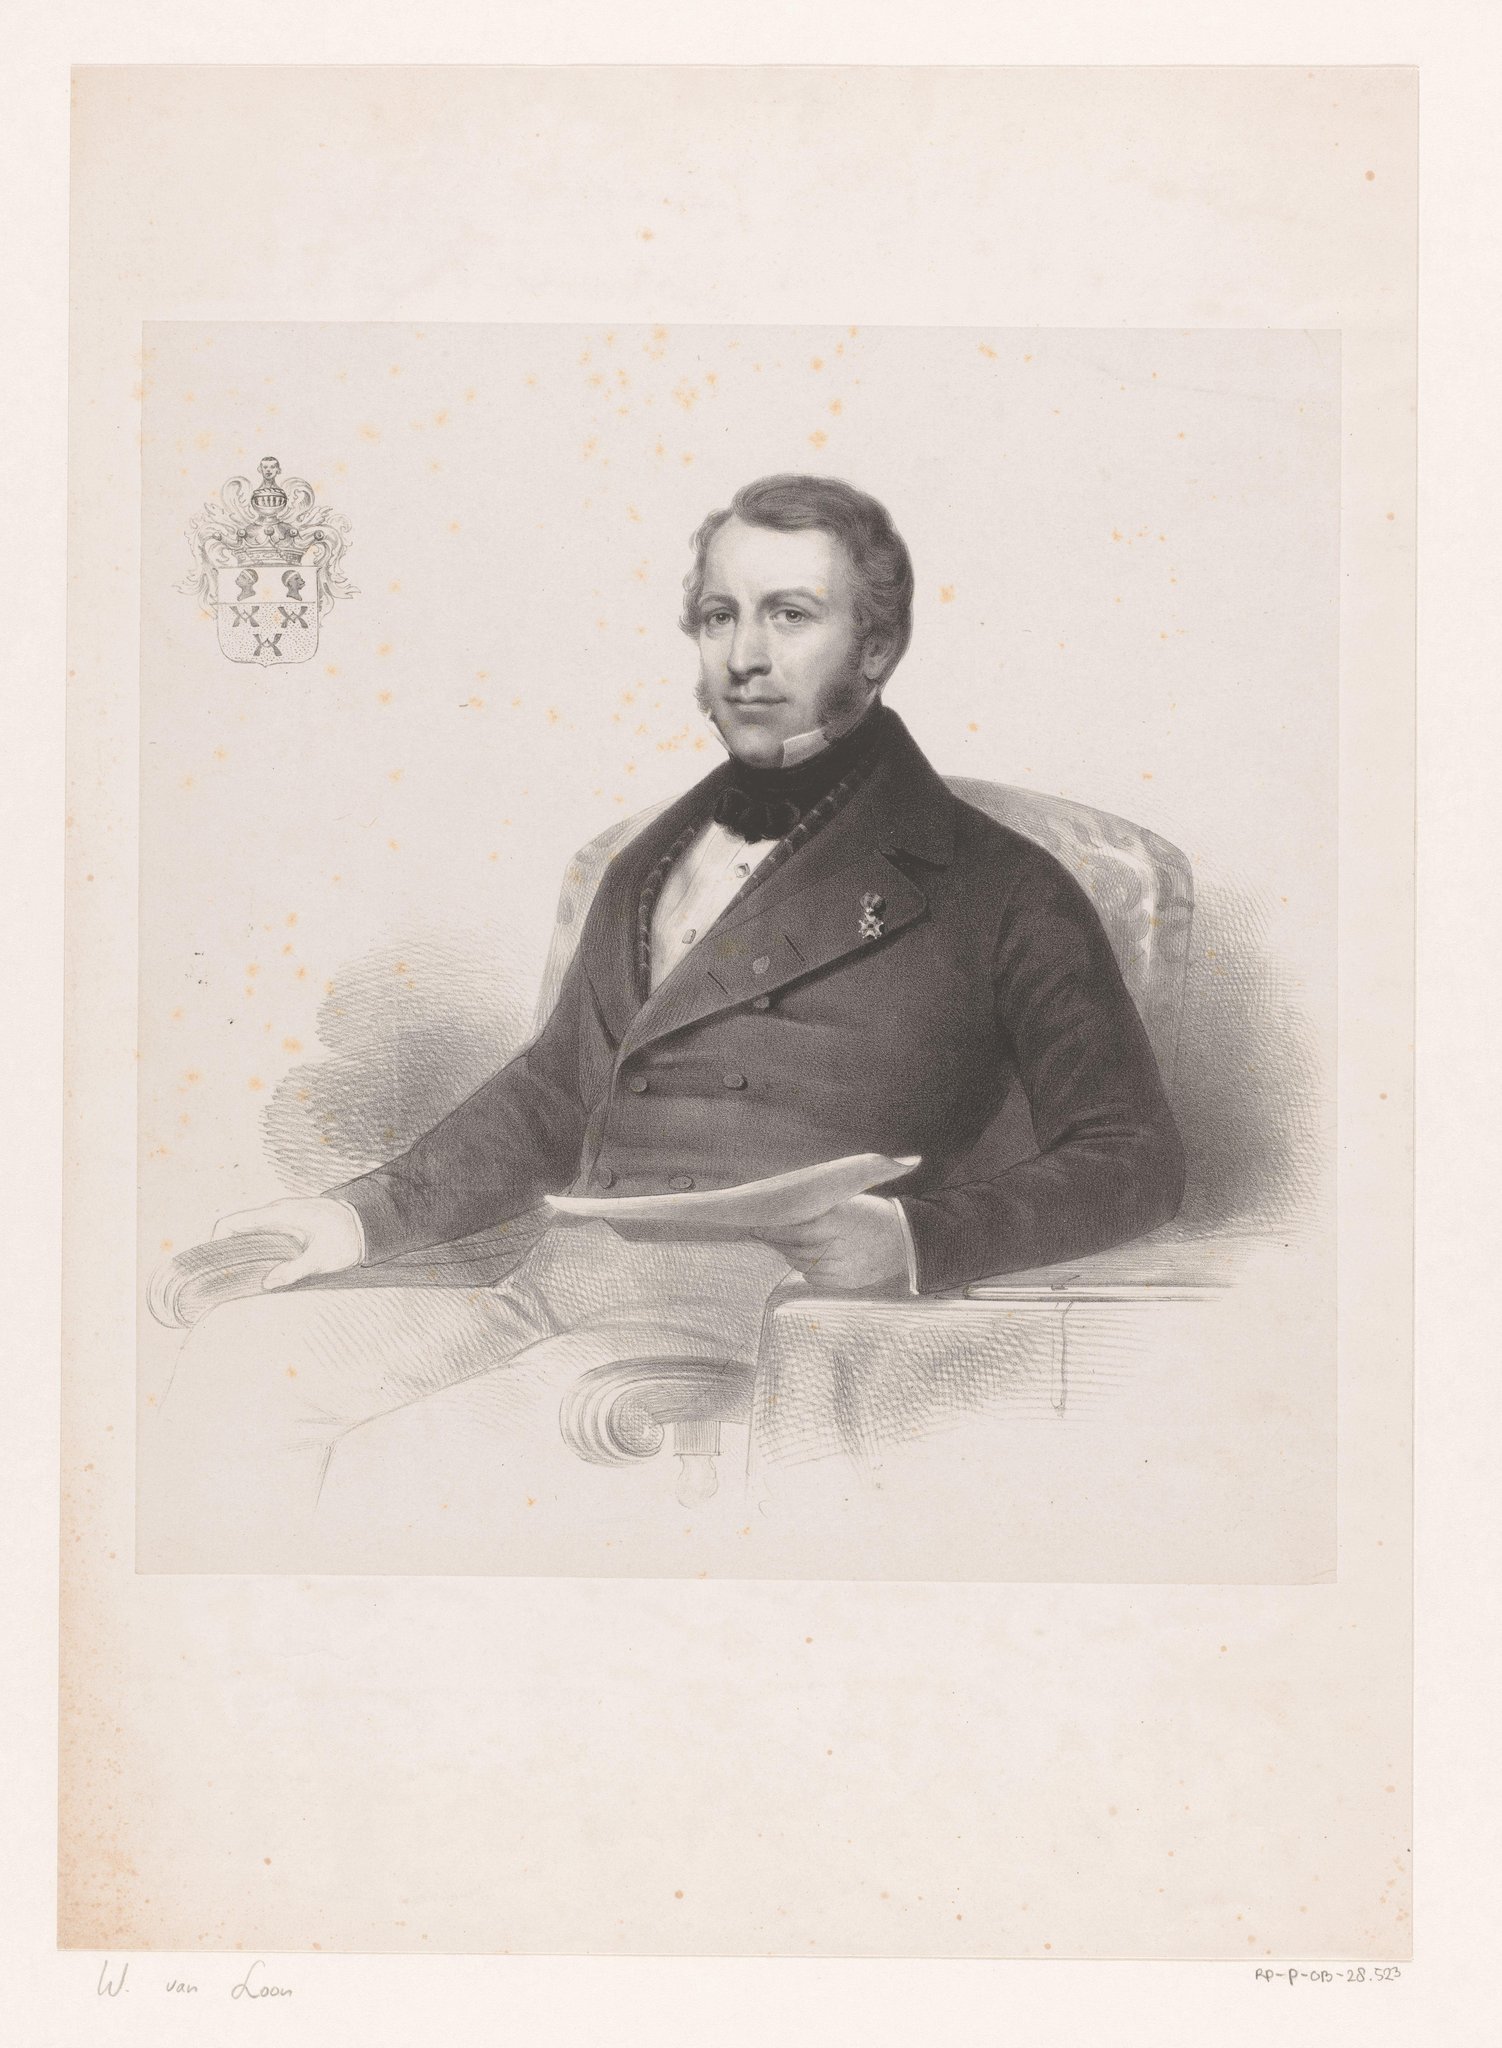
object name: print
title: Portret van Willem van Loon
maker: johan hendrik hoffmeister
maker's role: print maker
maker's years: 1823-1904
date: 1843-1904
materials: paper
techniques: lithograph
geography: netherlands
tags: amsterdam, knighthood order, armorial bearing, heraldry, historical persons (+ three-quarter length portrait)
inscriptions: collector's mark: Lugt 2228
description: Linksboven het familiewapen van de familie Van Loon.